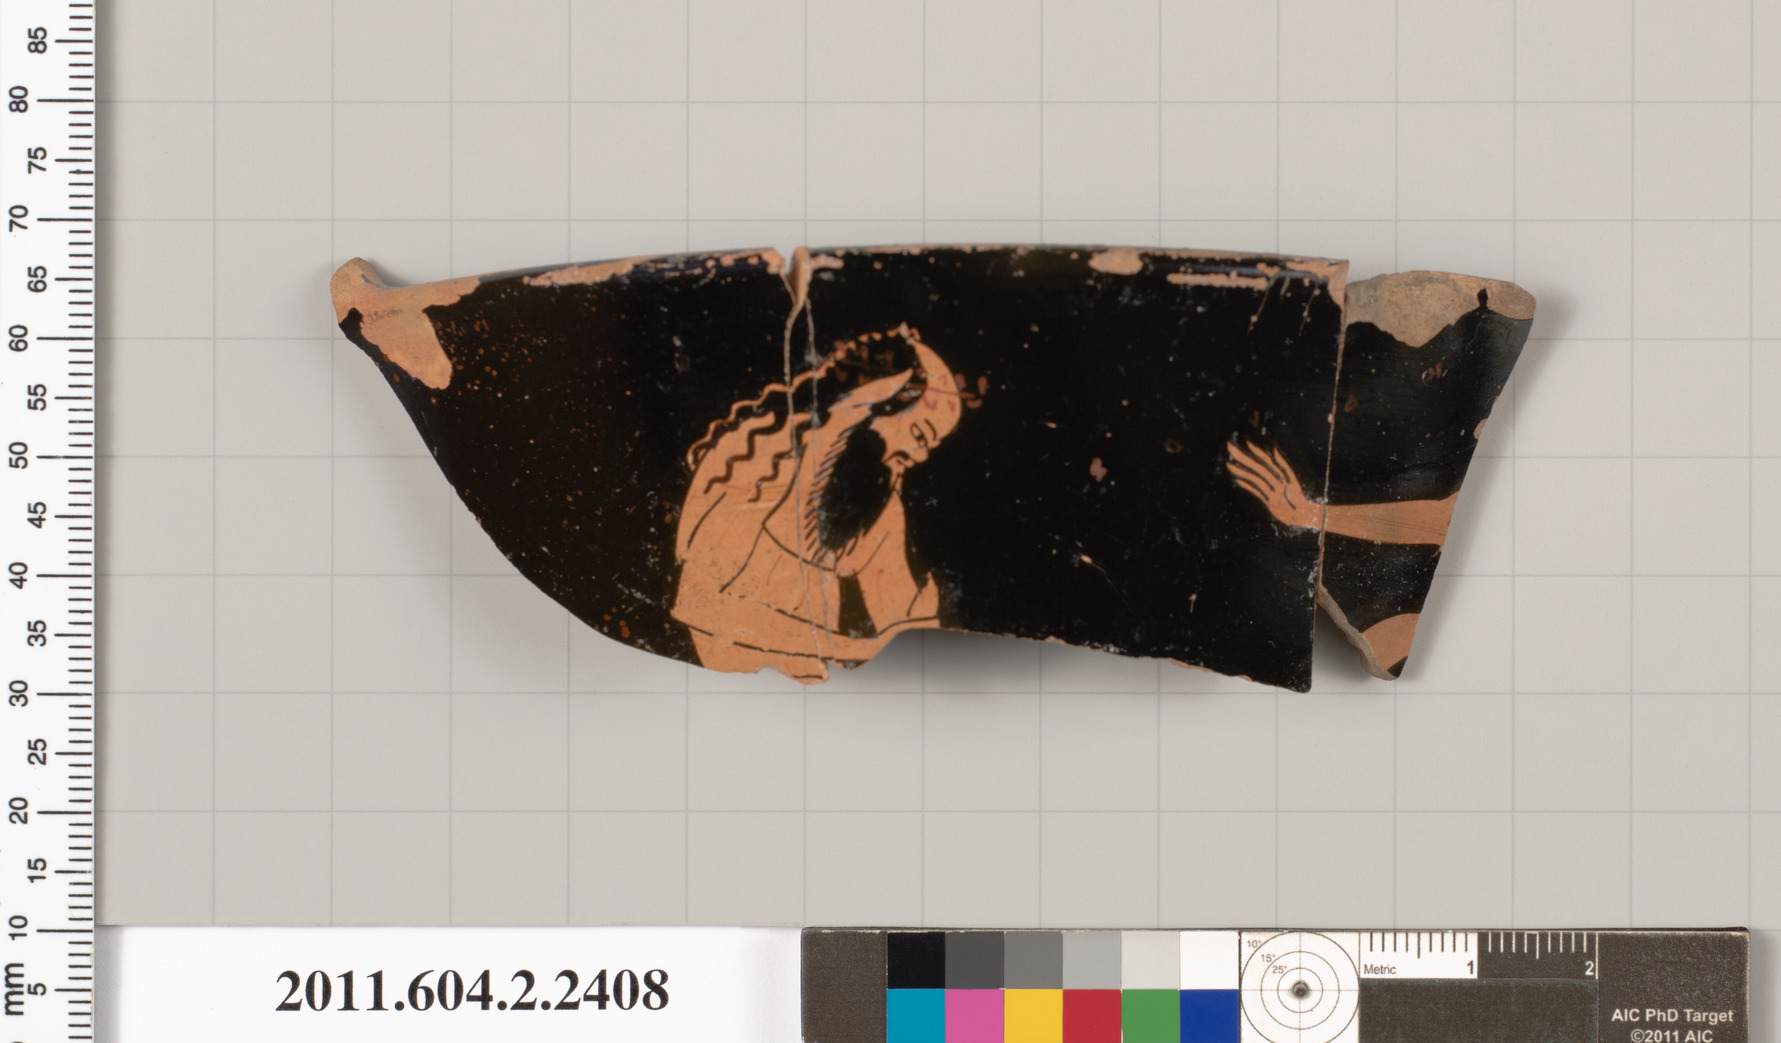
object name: kantharos fragment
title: Terracotta fragment of a head kantharos (drinking cup with high handles)?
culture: greek, attic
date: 470 BCE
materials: terracotta